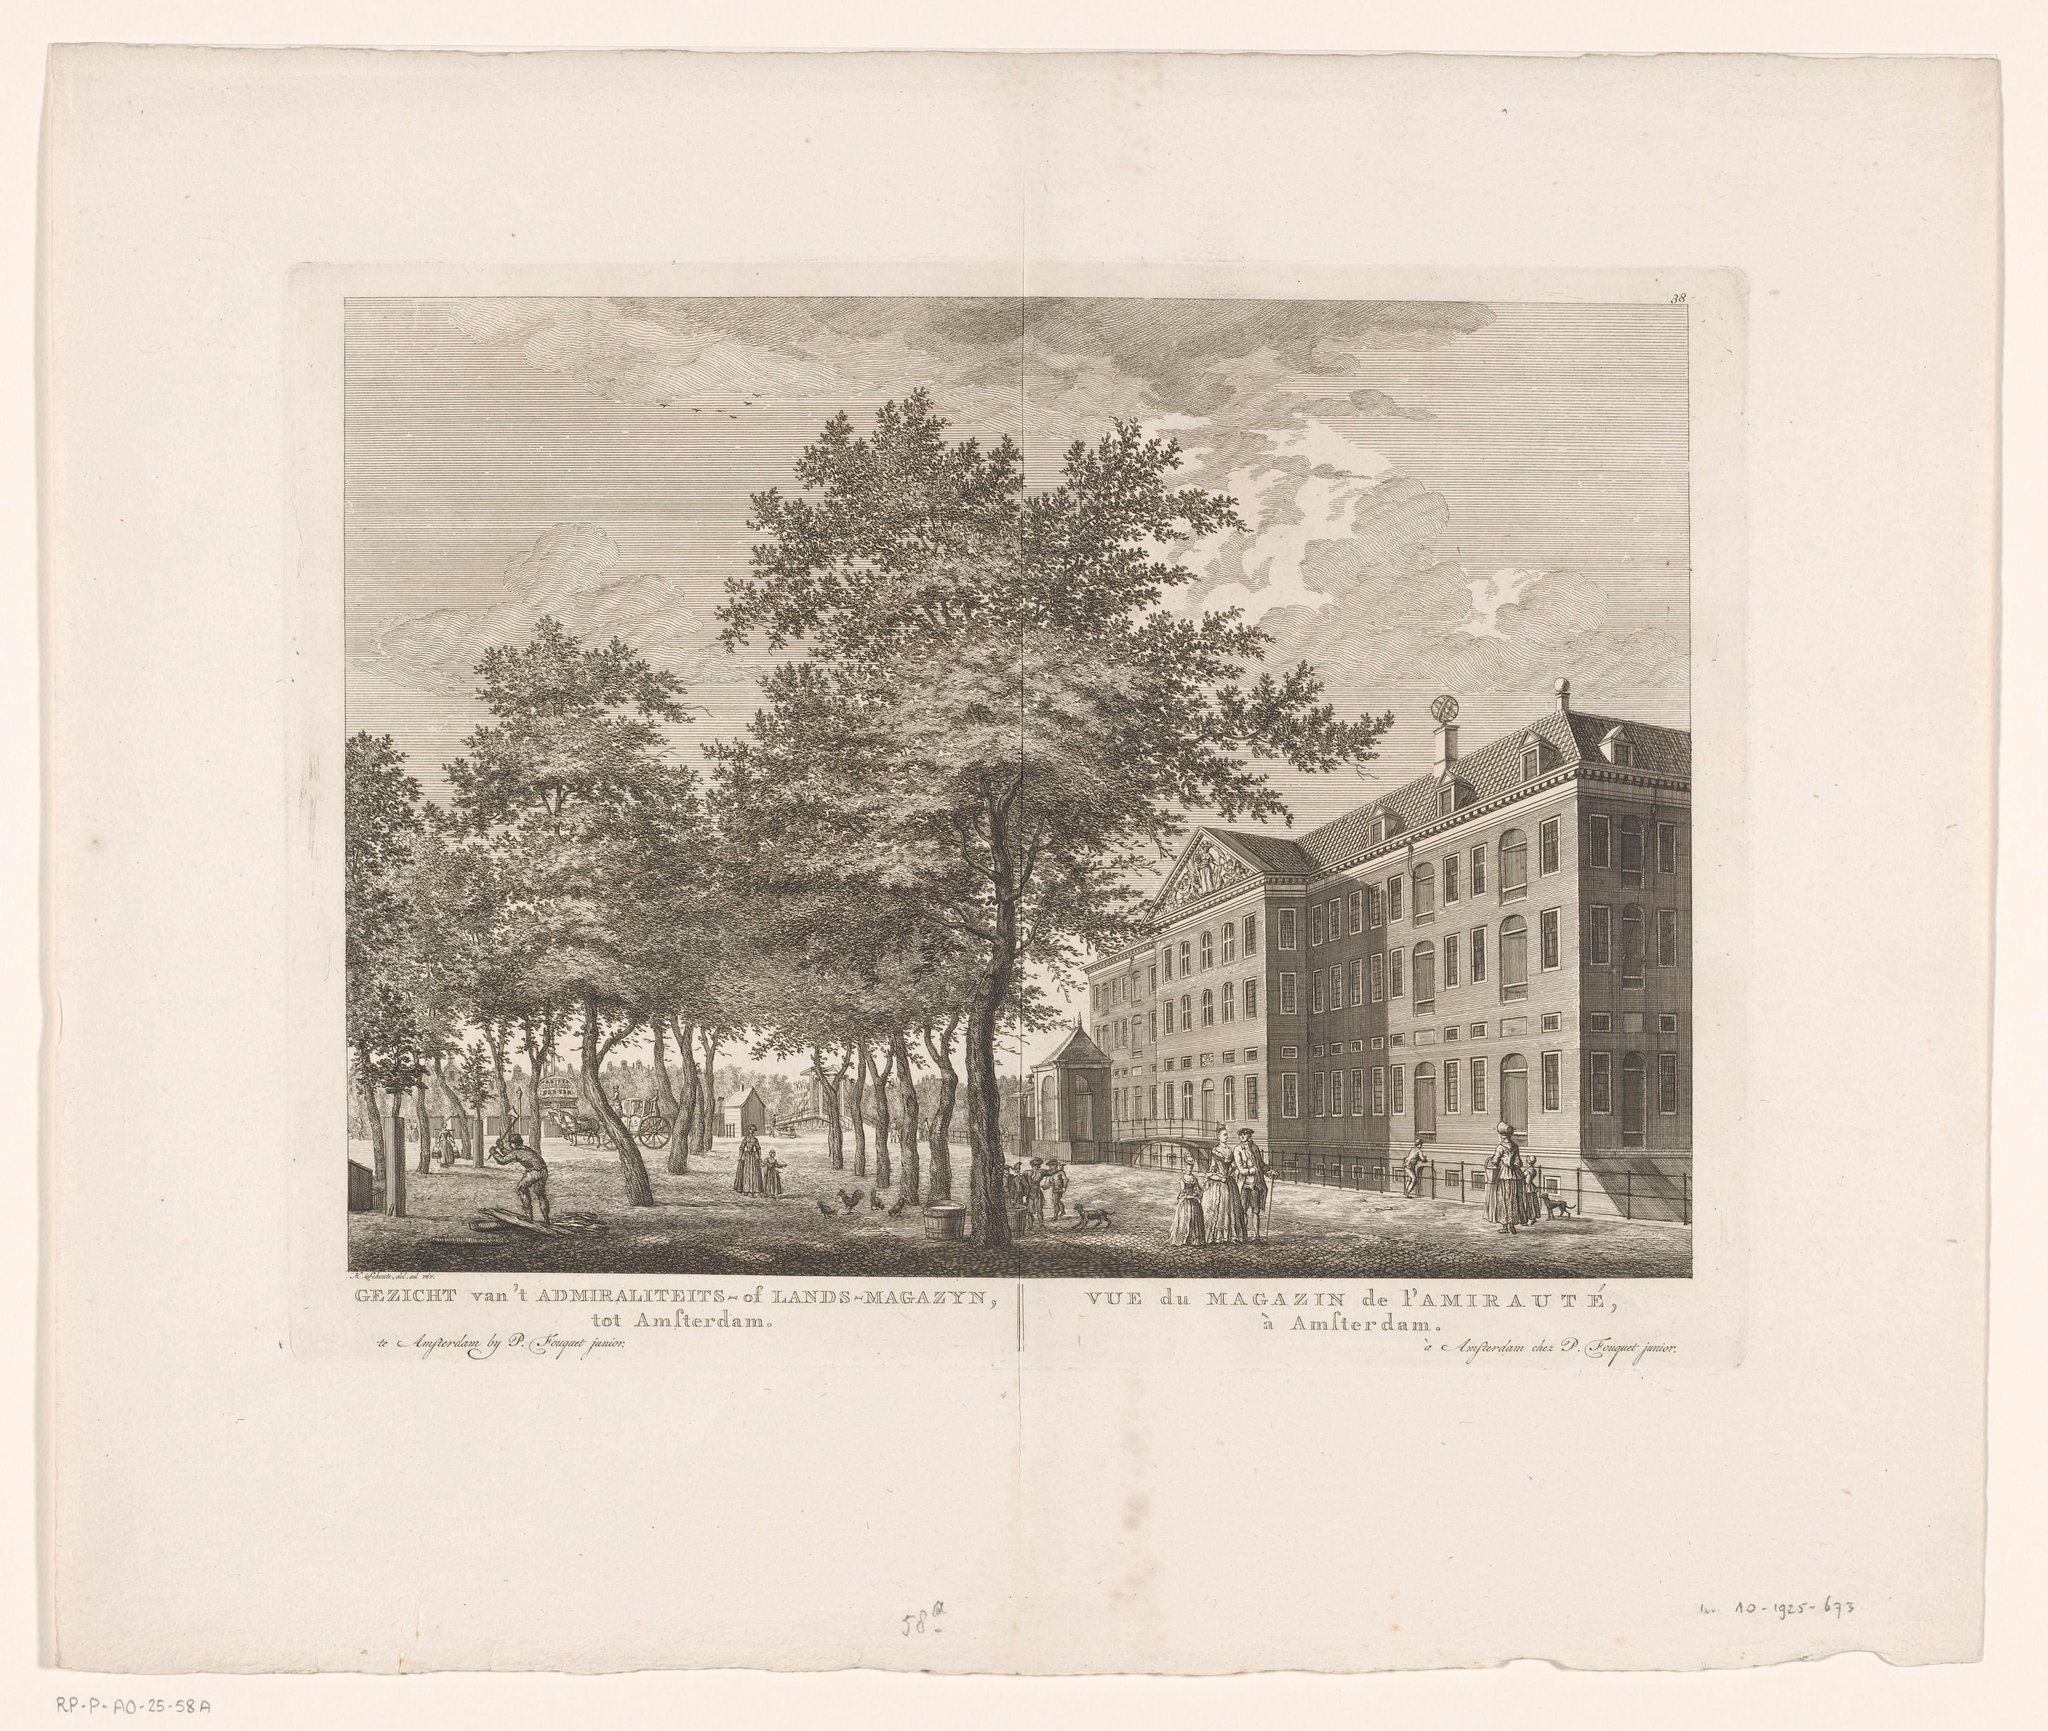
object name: print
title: Gezicht op 's Lands Zeemagazijn (Admiraliteitsmagazijn) te Amsterdam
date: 1770-1783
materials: paper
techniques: engraving, etching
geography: amsterdam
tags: large-scale structure for storage, e.g.: warehouse, depot, silo, bridge, square, place, circus, etc. (+ city(-scape) with figures, staffage), ammunition store, arsenal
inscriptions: collector's mark: Lugt 2228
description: Deze prent is ook gebruikt in de zogenaamde Atlas van Fouquet.* Pierre Fouquet gaf vanaf 1760 stadsgezichten van Amsterdam - naar tekeningen van verschillende kunstenaars, gemaakt door verschillende prentmakers - uit. Deze prenten werden aanvankelijk los of in series verkocht. Zoals toen gebruikelijk kon de koper de prenten zelf laten inbinden. Hiertoe gaf Fouquet tussen 1778 en 1783 een titelblad, plattegrond en inhoudsopgave van de tot dusver 100 uitgegeven prenten uit (1). Gezien de inhoud afhankelijk was van wat de koper had verzameld verschilt de inhoud van de verschillende bewaarde Fouquetatlassen onder deze titel sterk. Ook zijn er exemplaren bekend waar tevens andere prenten aan zijn toegevoegd. Omdat er behoefte bleek aan uitleg bij de platen werd in 1783 een nieuwe versie van de atlas uitgegeven, aangevuld met tekst en twee prenten. De aangegeven volgorde veranderde maar de platen van de al eerder uitgegeven prenten bleven ongewijzigd. Deze uitgave werd in opdracht van Fouquet gedrukt bij Daniël Jean Changuion en Petrus den Hengst (2). Een tiental platen werd bijgewerkt en verscheen, met nieuw impressum, in het vervolg van Wagenaars geschiedenis van Amsterdam, uitgeven door Petrus Conradi en Folkert van der Plaats (3). Een aantal jaar na het overlijden van Fouquet kwam Evert Maaskamp met een nieuwe uitgave van de atlas, met verbeterde tekst en toevoeging van twee prenten. Op alle platen verwijderde hij het oude en liet hij zijn eigen impressum zetten (4). De huidige staat van de prent komt voor in exemplaren van de onder (1) en (2) genoemde werken. * Onder de Atlas van Fouquet of Fouquetatlas verstaan we de hieronder vermelde publicaties (1), (2) en (4). (1). Afbeeldingen van de wyd-vermaarde koopstad Amsterdam benevens des zelvs voornaamste gebouwen en gezigten alle naar het leeven getekend / Receuil des edifices les plus considerables et des plus belles vues, de la fameuse ville d'Amsterdam, dessinées d'après nature. Amsterdam: Pierre Fouquet, 1778-1783. (2). Nieuwe atlas, van de voornaamste gebouwen en gezigten der stad Amsterdam, met derzelver beknopte beschryvingen. 2 delen. Amsterdam: Daniël Jean Changuion en Petrus den Hengst [in opdracht van Pierre Fouquet], 1783. (3). Stijl, Simon. Amsterdam, in zyne geschiedenissen, voorregten, koophandel, gebouwen, kerkenstaat, schoolen, schutterye, gilden en regeeringe, beschreeven. Om te dienen ten vervolge op het werk van Jan Wagenaar (…). 10 delen. Amsterdam en Harlingen: Petrus Conradi en Folkert van der Plaats, 1788-1801. (4). Nieuwe atlas, van de voornaamste gebouwen en gezigten der stad Amsterdam. Met derzelver beknopte beschryvingen. Amsterdam: Evert Maaskamp, 1805. * Het aantal vermelde staten is gebaseerd op het aantal gevonden staten. Mogelijk zijn er meer staten van deze prent. Zie RP-P-1998-758 voor derde bekende staat.